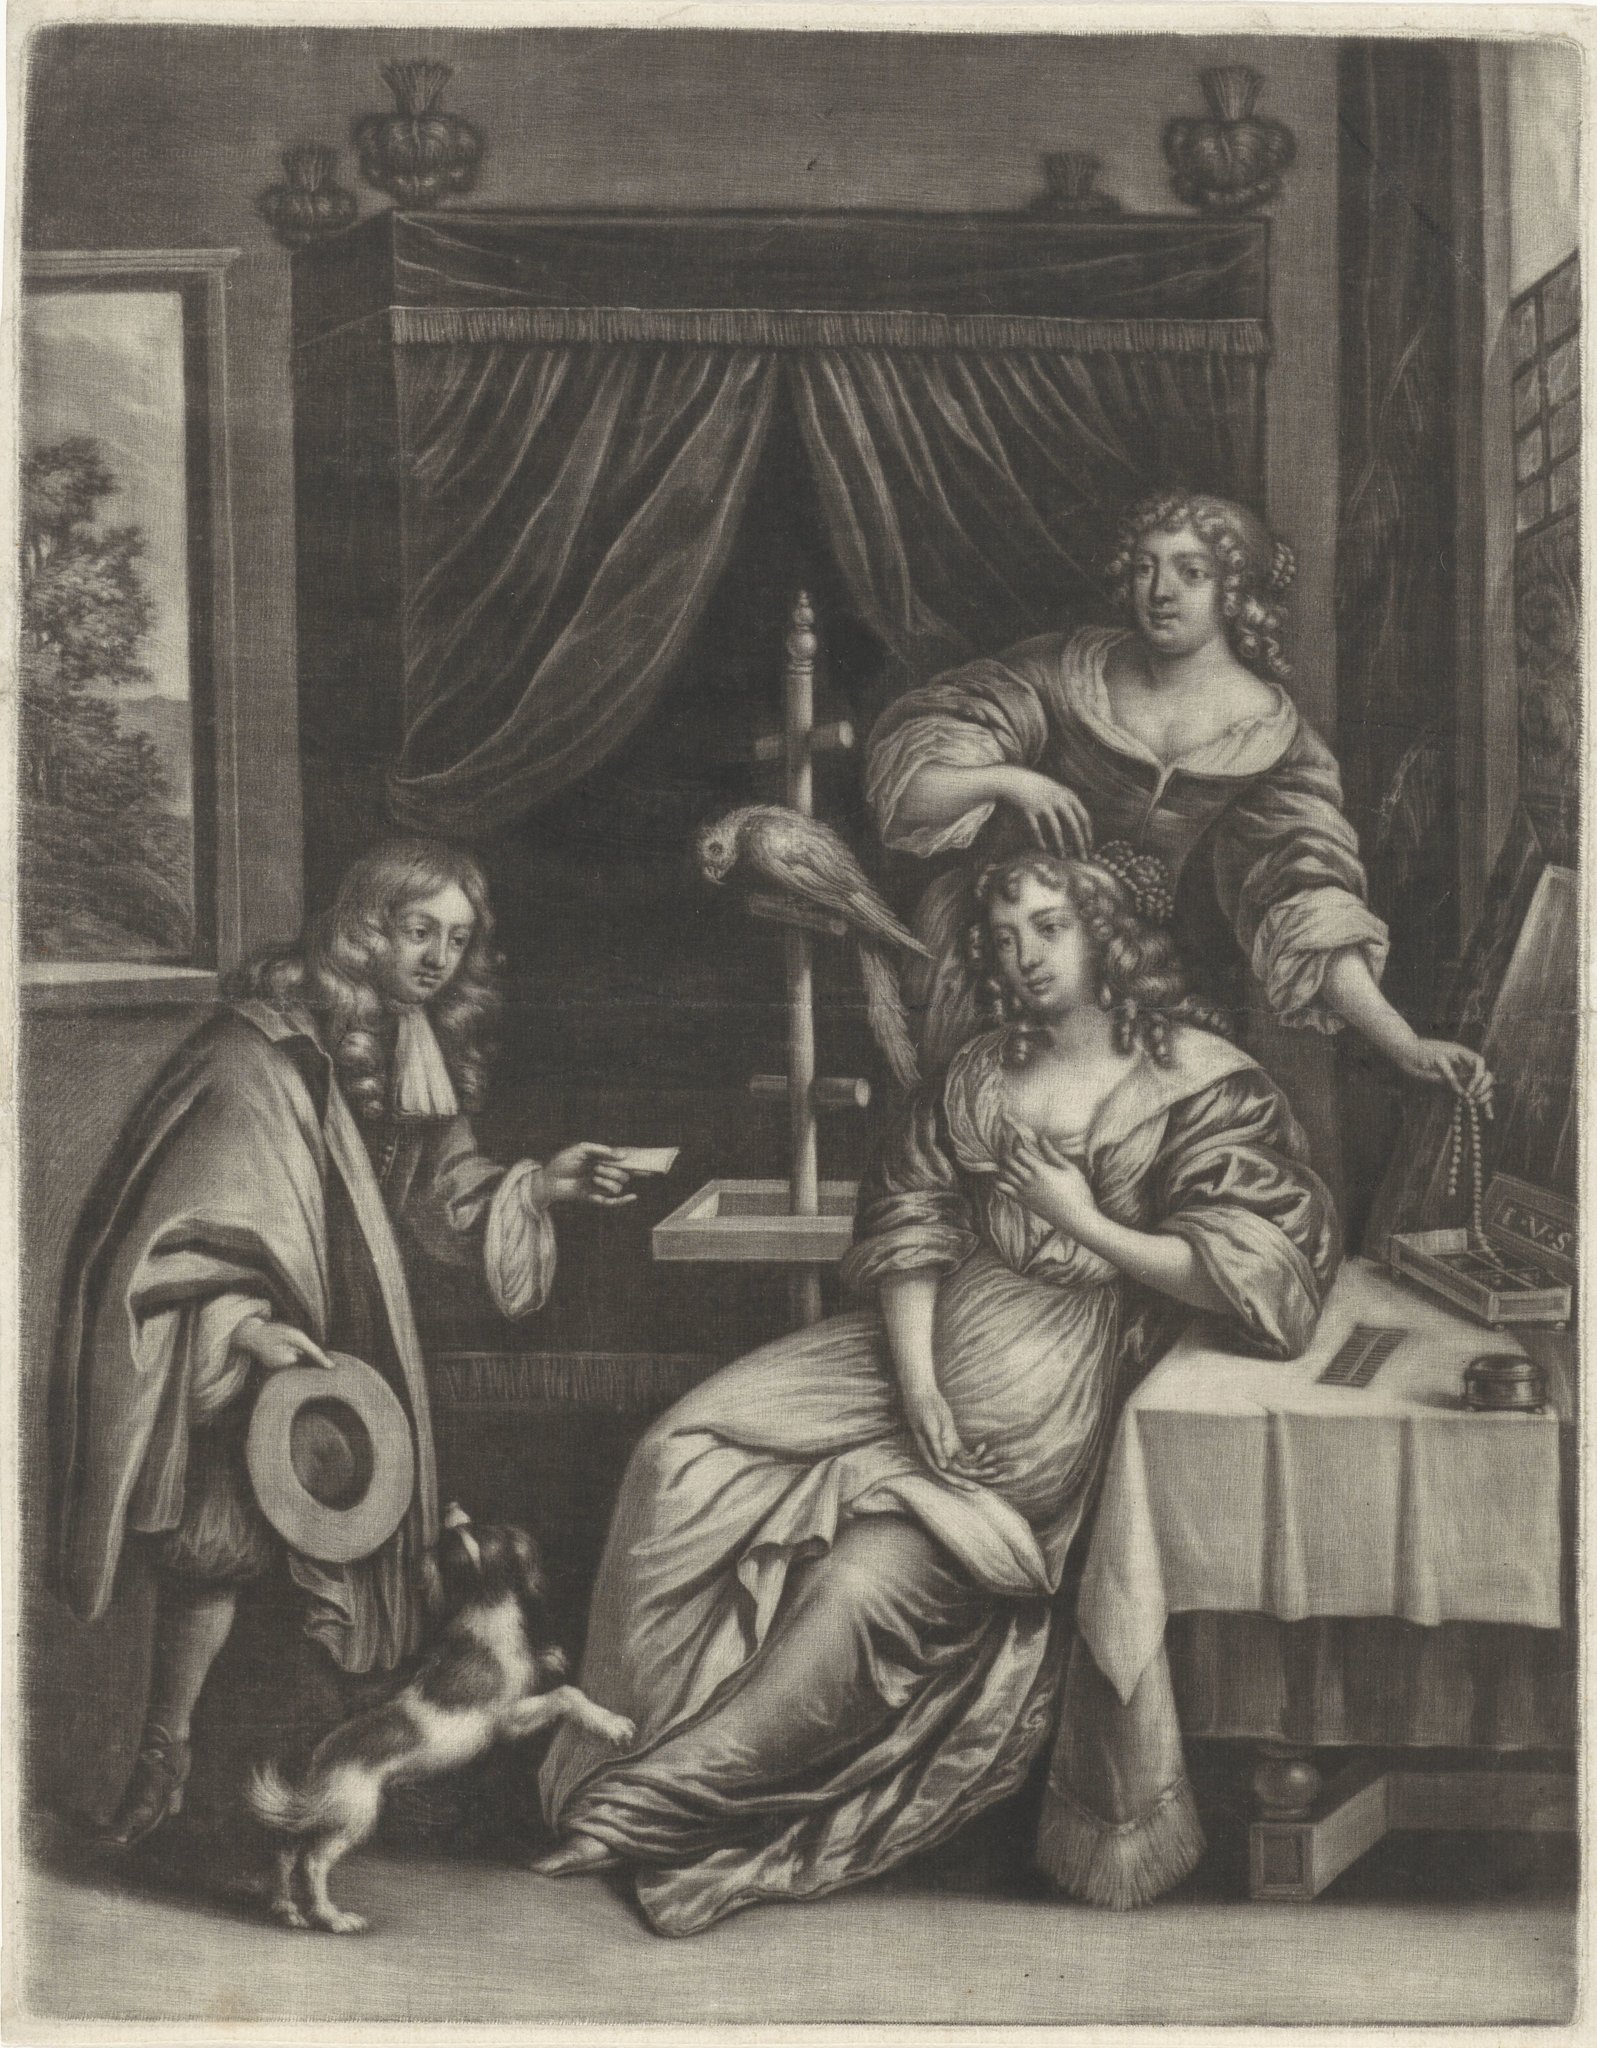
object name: print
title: Bode brengt een brief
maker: jan van somer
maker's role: draughtsman, print maker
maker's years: 1645-1699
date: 1655-1700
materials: paper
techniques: mezzotint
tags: ornamental birds: peacock, letter, envelope, necklace (+ women's clothes), dog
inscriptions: collector's mark: Lugt 2228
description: Een man reikt een brief aan, aan een vrouw die gekapt wordt. Naast de kaptafel een papegaai op een stok.